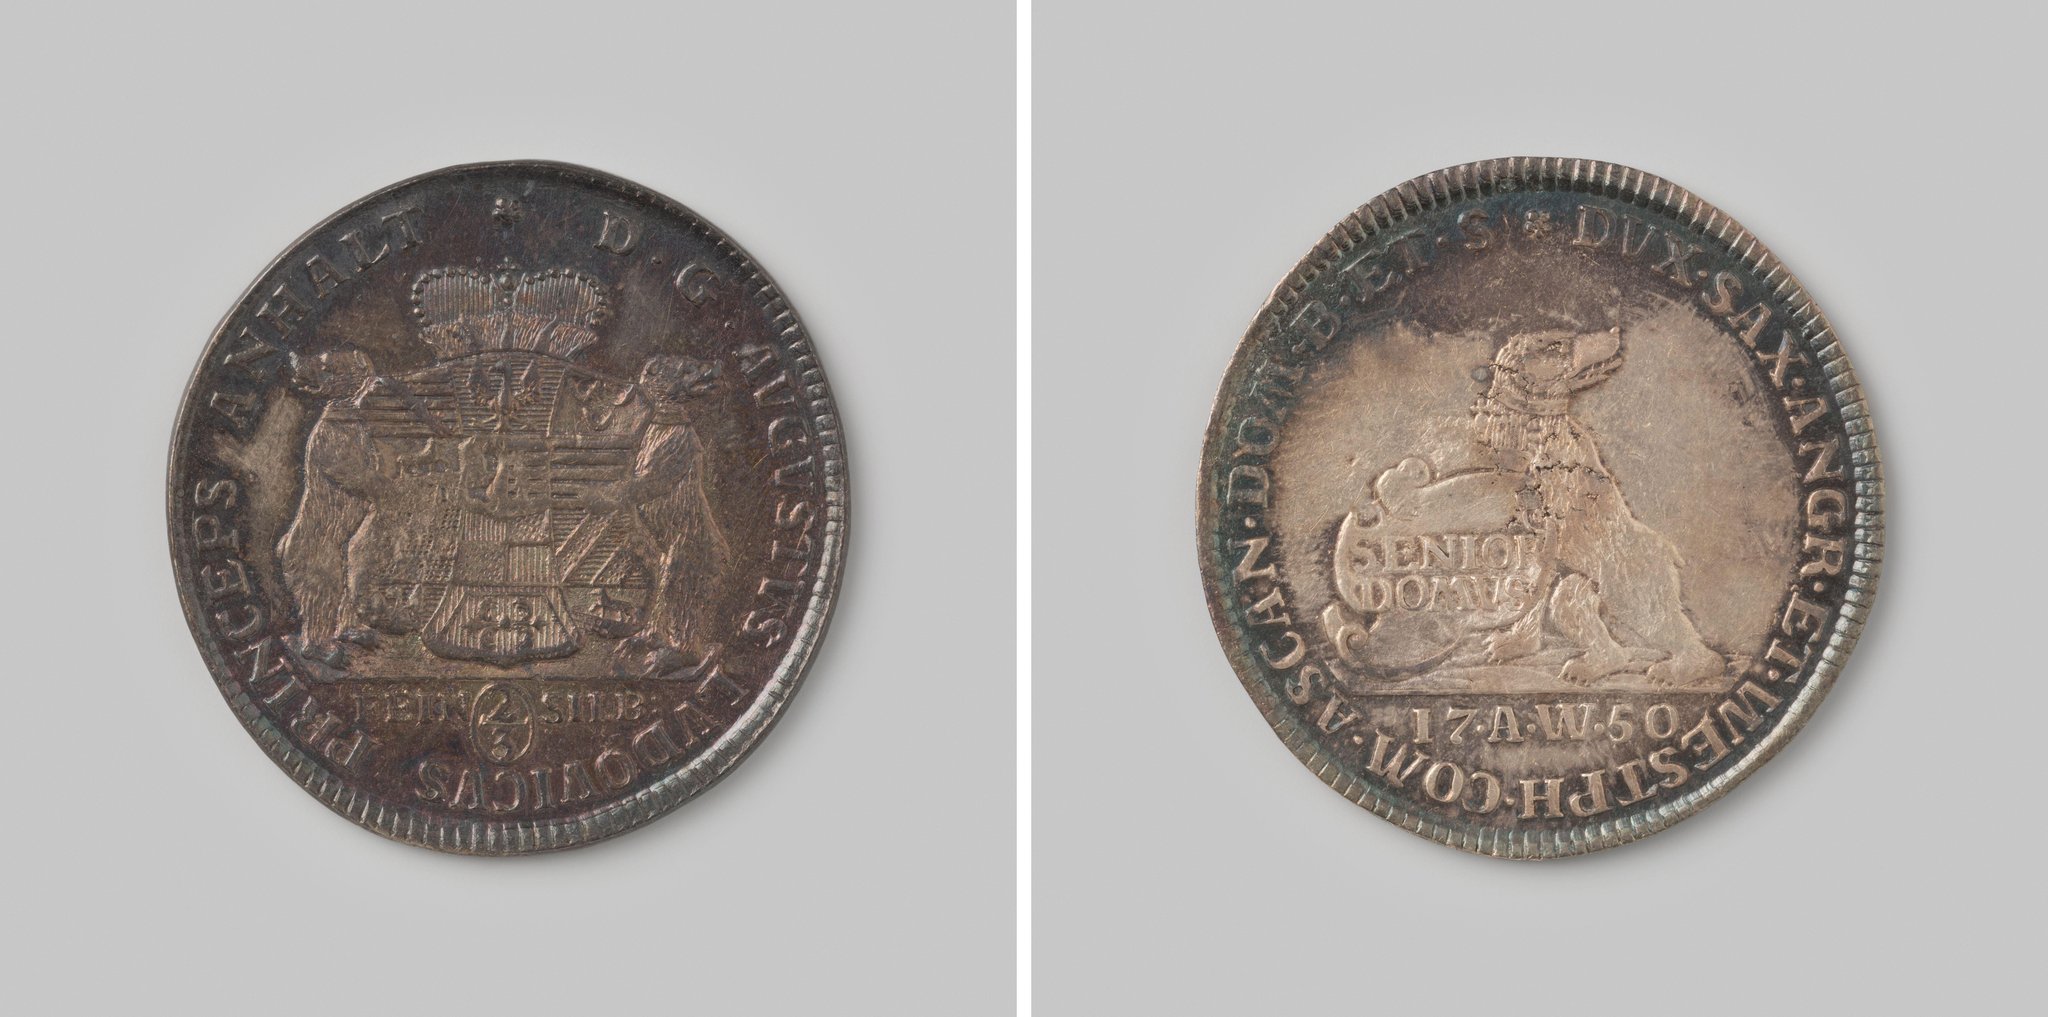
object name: coin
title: Anhalt-Köthen, August I Ludwig, gulden, 1750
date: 1750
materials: silver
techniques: striking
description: Zilveren munt. Voorzijde: door twee beren met halsband gehouden samengesteld wapenschild. Daaronder waarde-aanduiding: 2/3 [taler]. Keerrzijde: door op grond staande beer met halsband gehouden schild, waarop twee-regelig opschrift. Jaartal in afsnede. Gladde rand.